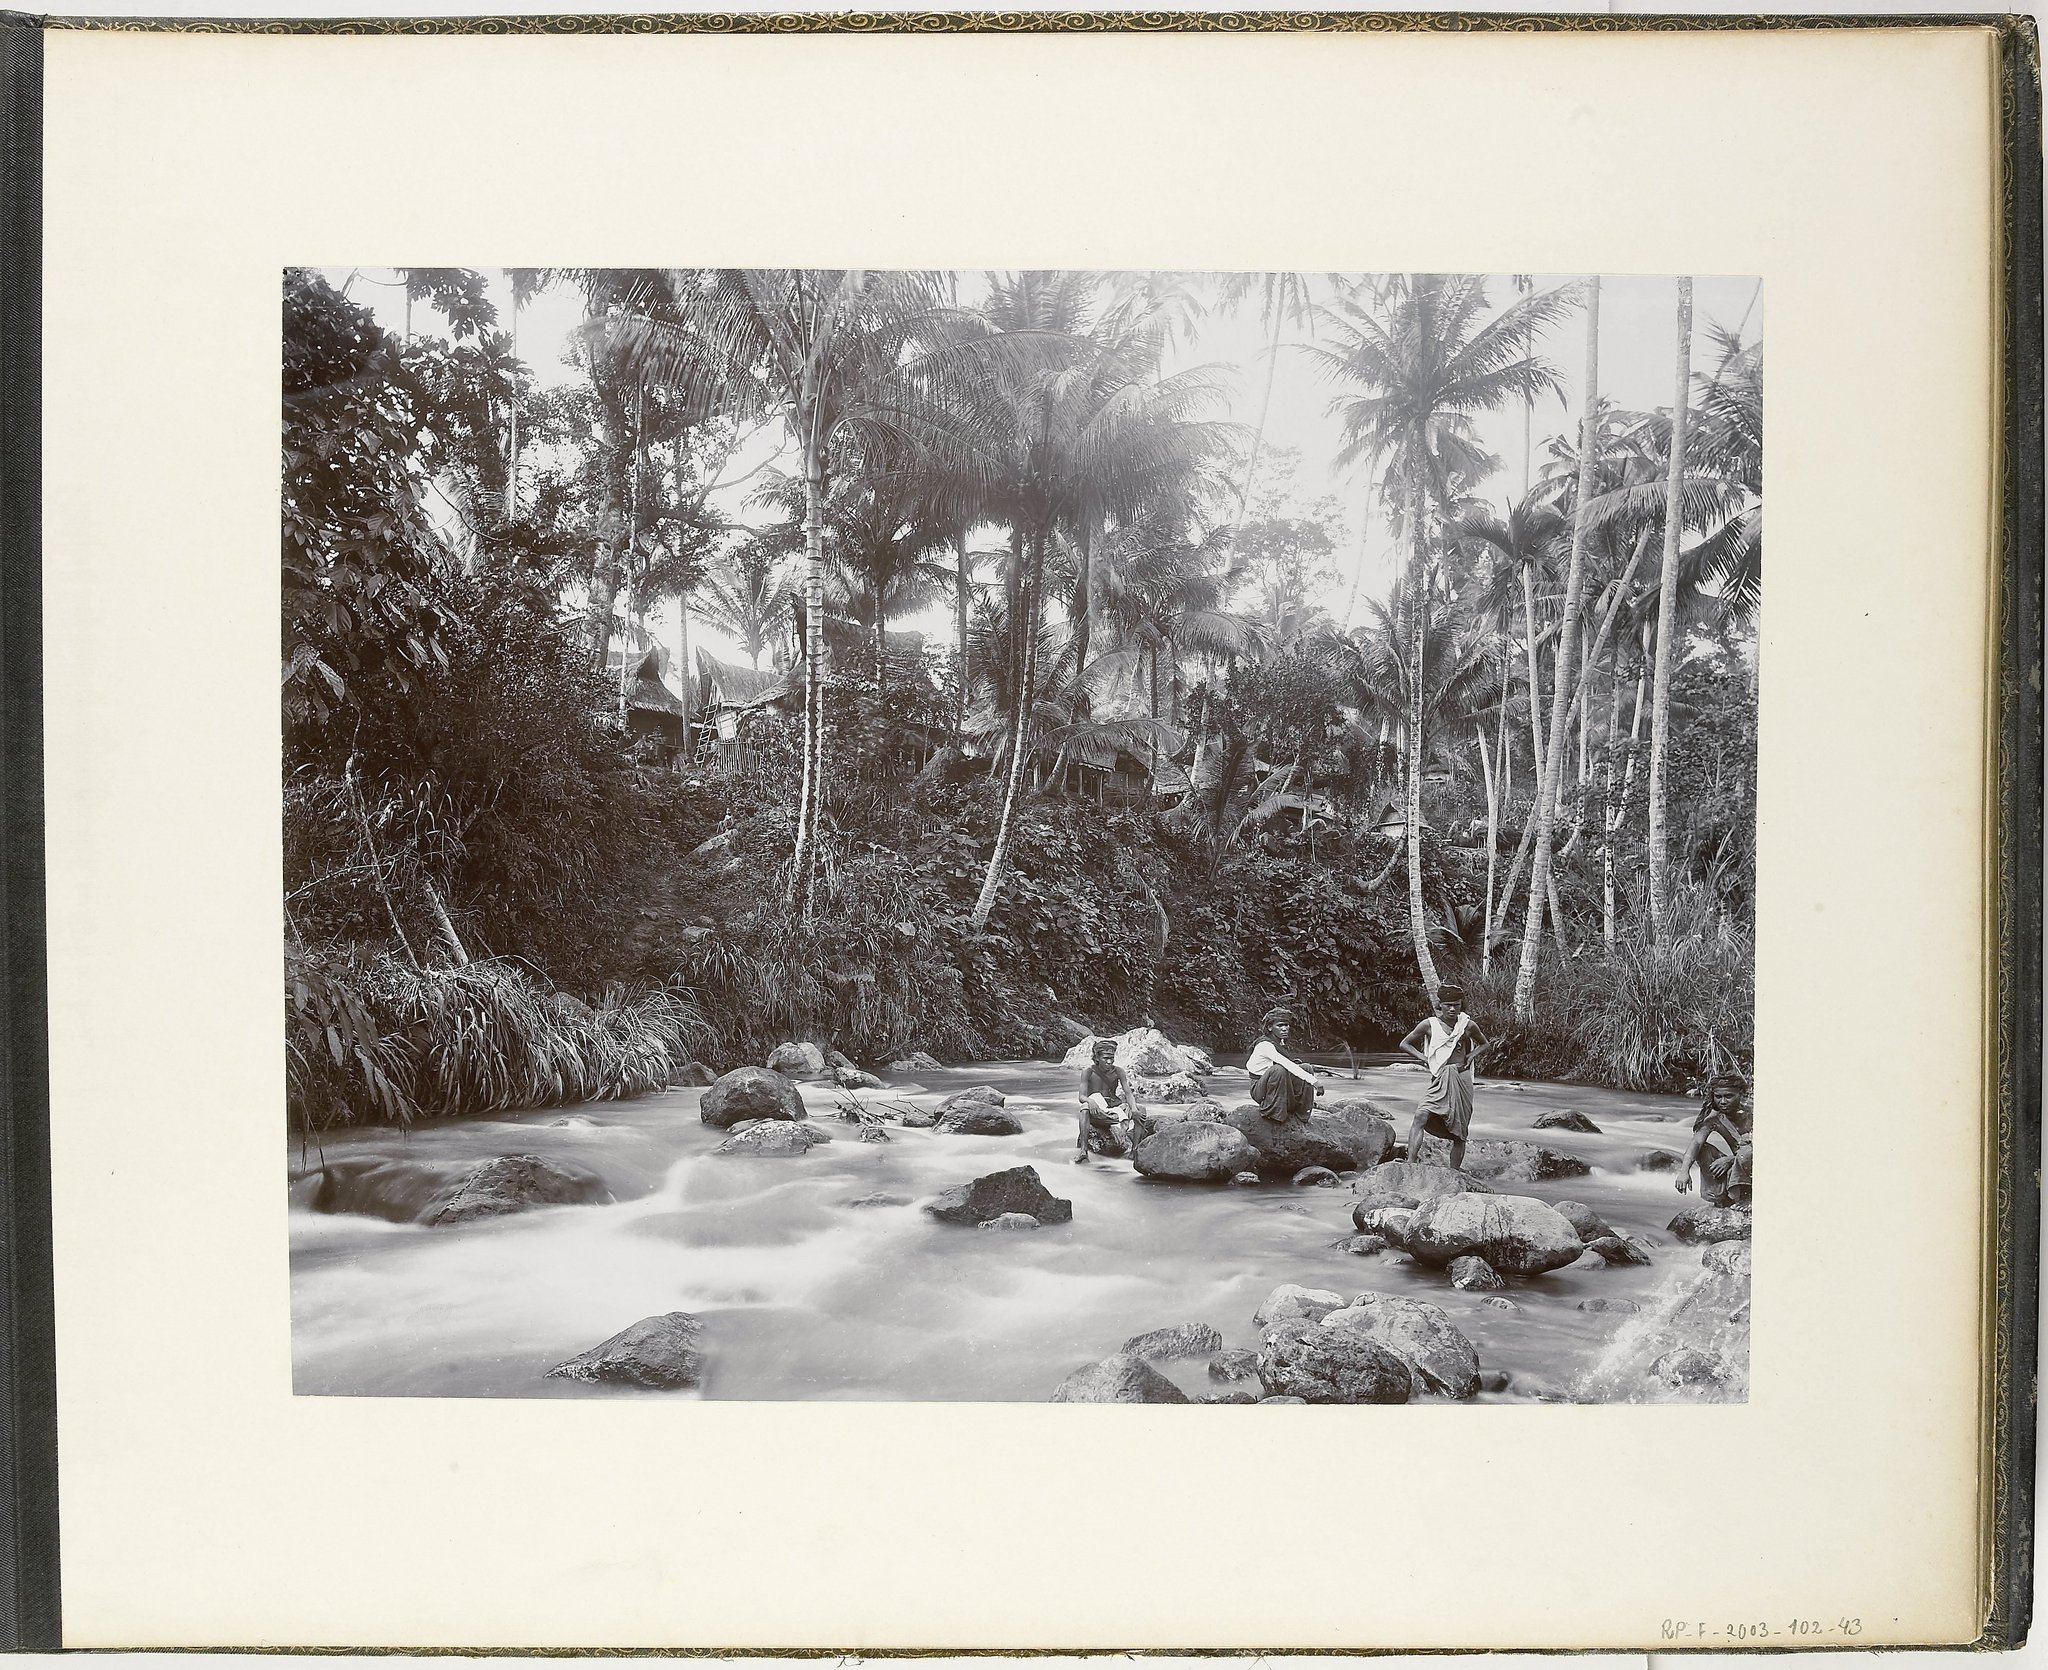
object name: photograph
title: Gezicht op Battak Kampong Roemah Kinangkang, Sumatra (Battak Kampong Roemah Kinangkang)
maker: carl j. kleingrothe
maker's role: fotograaf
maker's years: 1864-1925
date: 1885-1900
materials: photographic support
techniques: collodion silver print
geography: sumatra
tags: sumatra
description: Enkele inwoners van het Batakdorp Roemahkiwangkoeng in Boven-Deli in de Oostkust van Sumatra poseren op rotsen in een rivier. Onderdeel van het Sumatra fotoalbum van Paul en Lucie Sandel uit 1900.